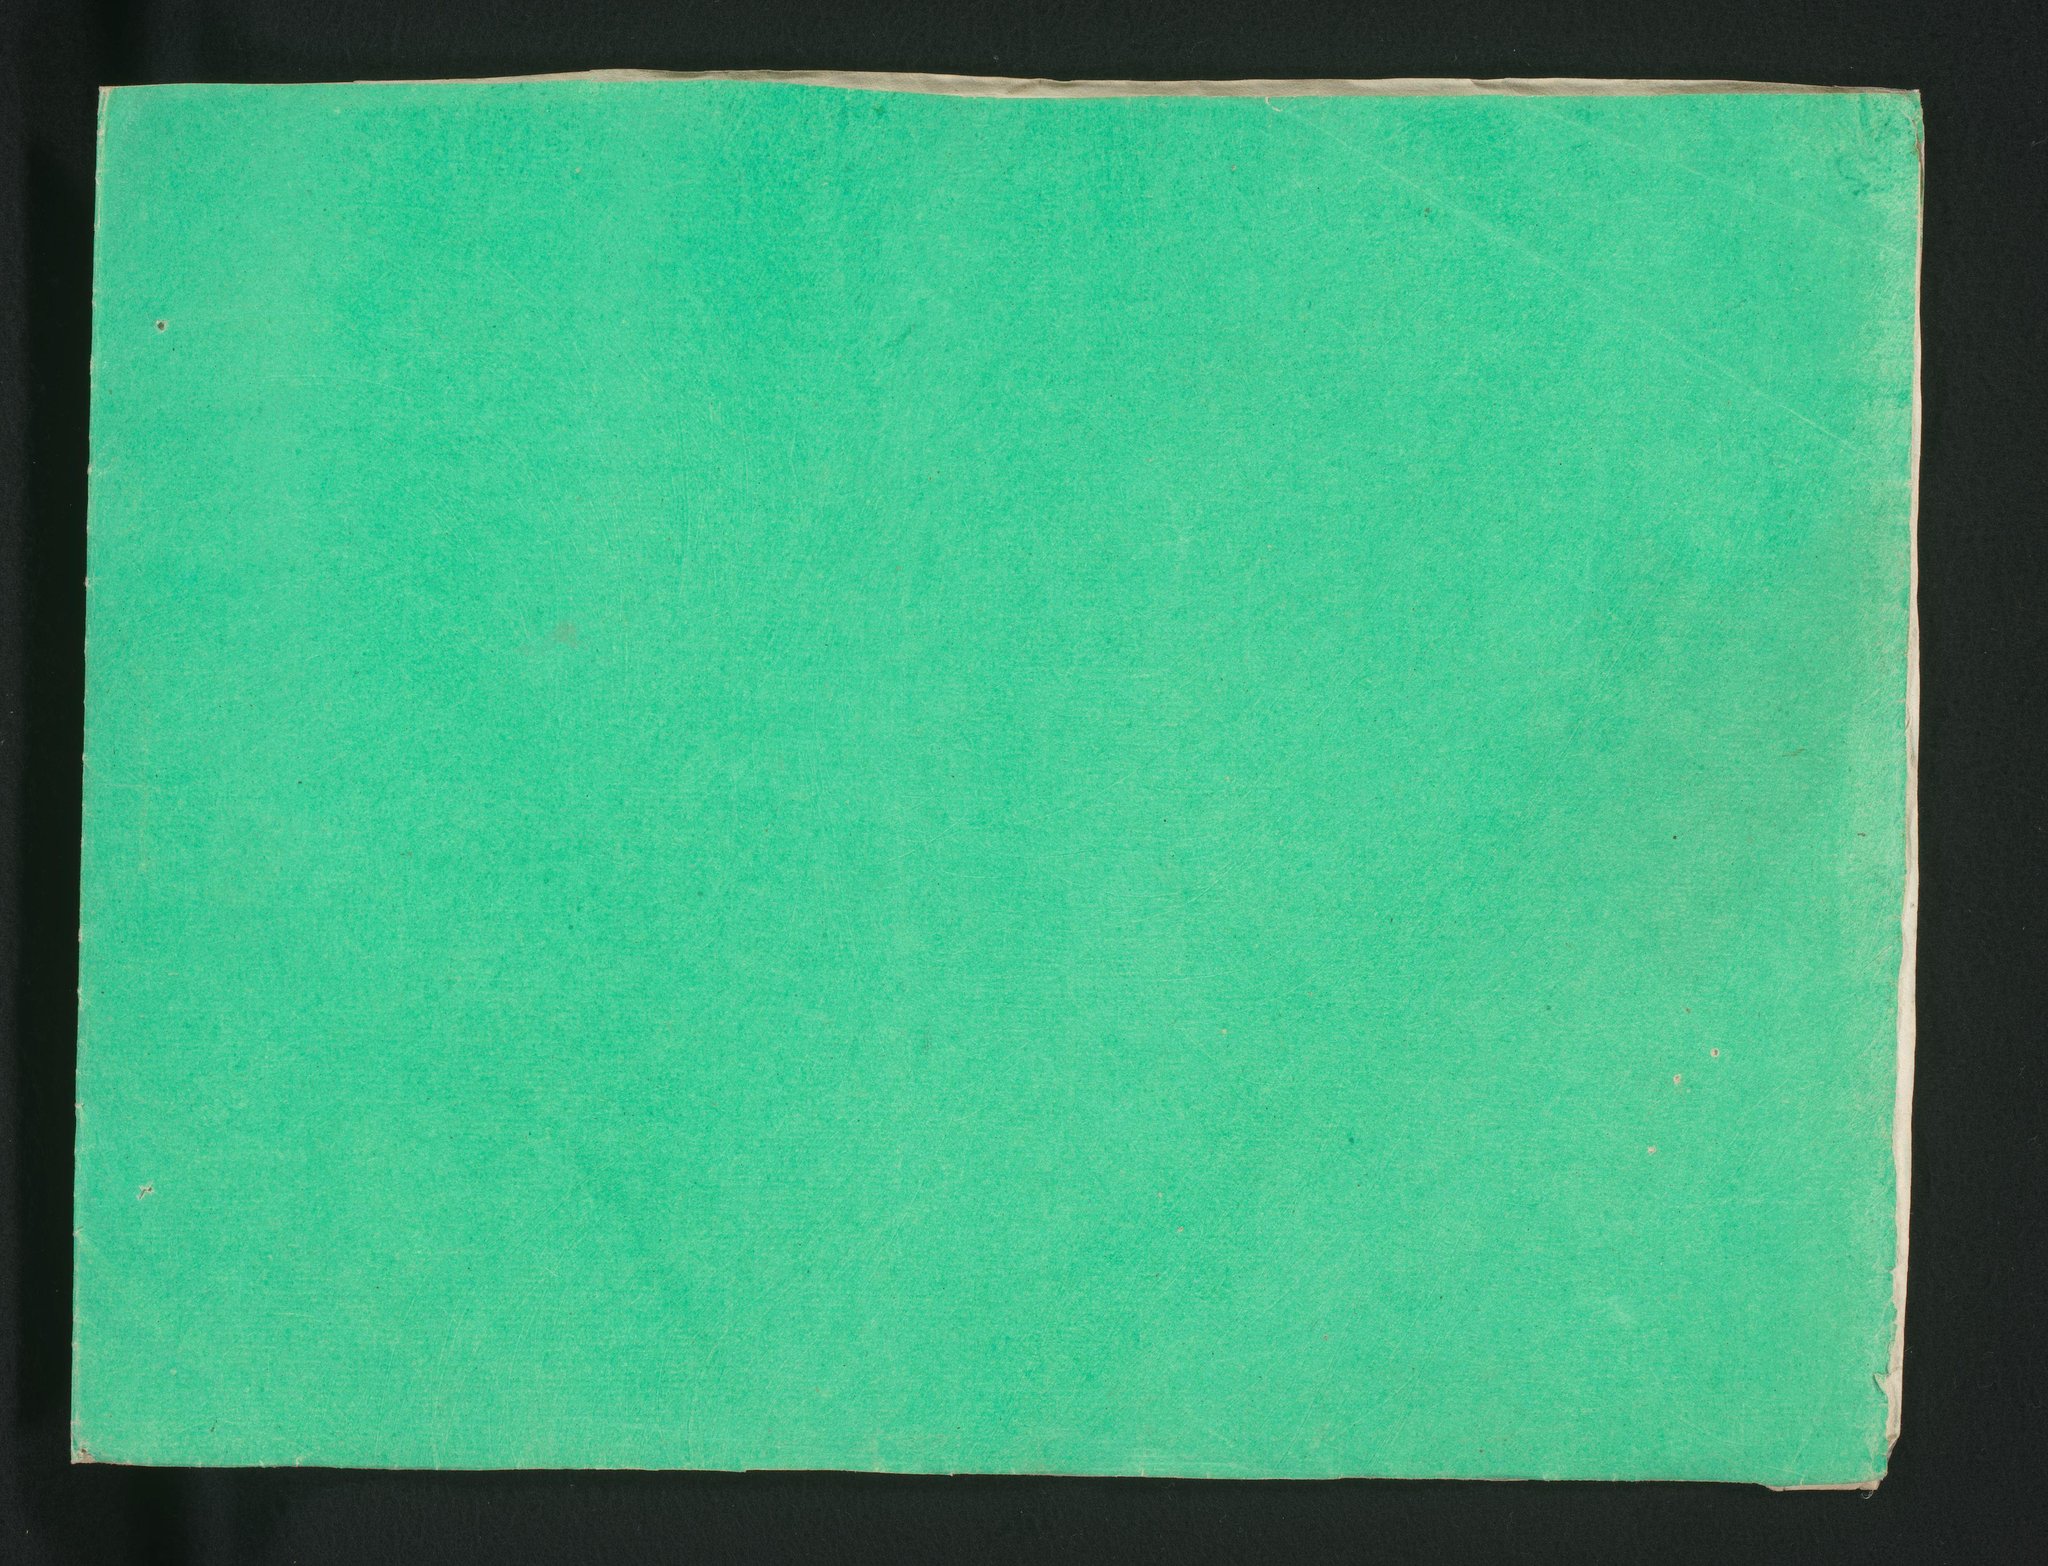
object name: prentrecueil, prentenalbum, prentalbum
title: Album met vier tekenvoorbeelden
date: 1800-1825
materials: paper, fiber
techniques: bookbinding, printmaking, engraving, etching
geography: paris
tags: trough, well, landscapes, tent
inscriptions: collector's mark: Lugt 2228, collector's mark: Lugt 2760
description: Album met vier prenten op vier bladen. De ongenummerde prenten met figuren zijn bedoeld als tekenvoorbeeld voor de jeugd. Prenten behoren tot de serie '2me. cahier d'études'.